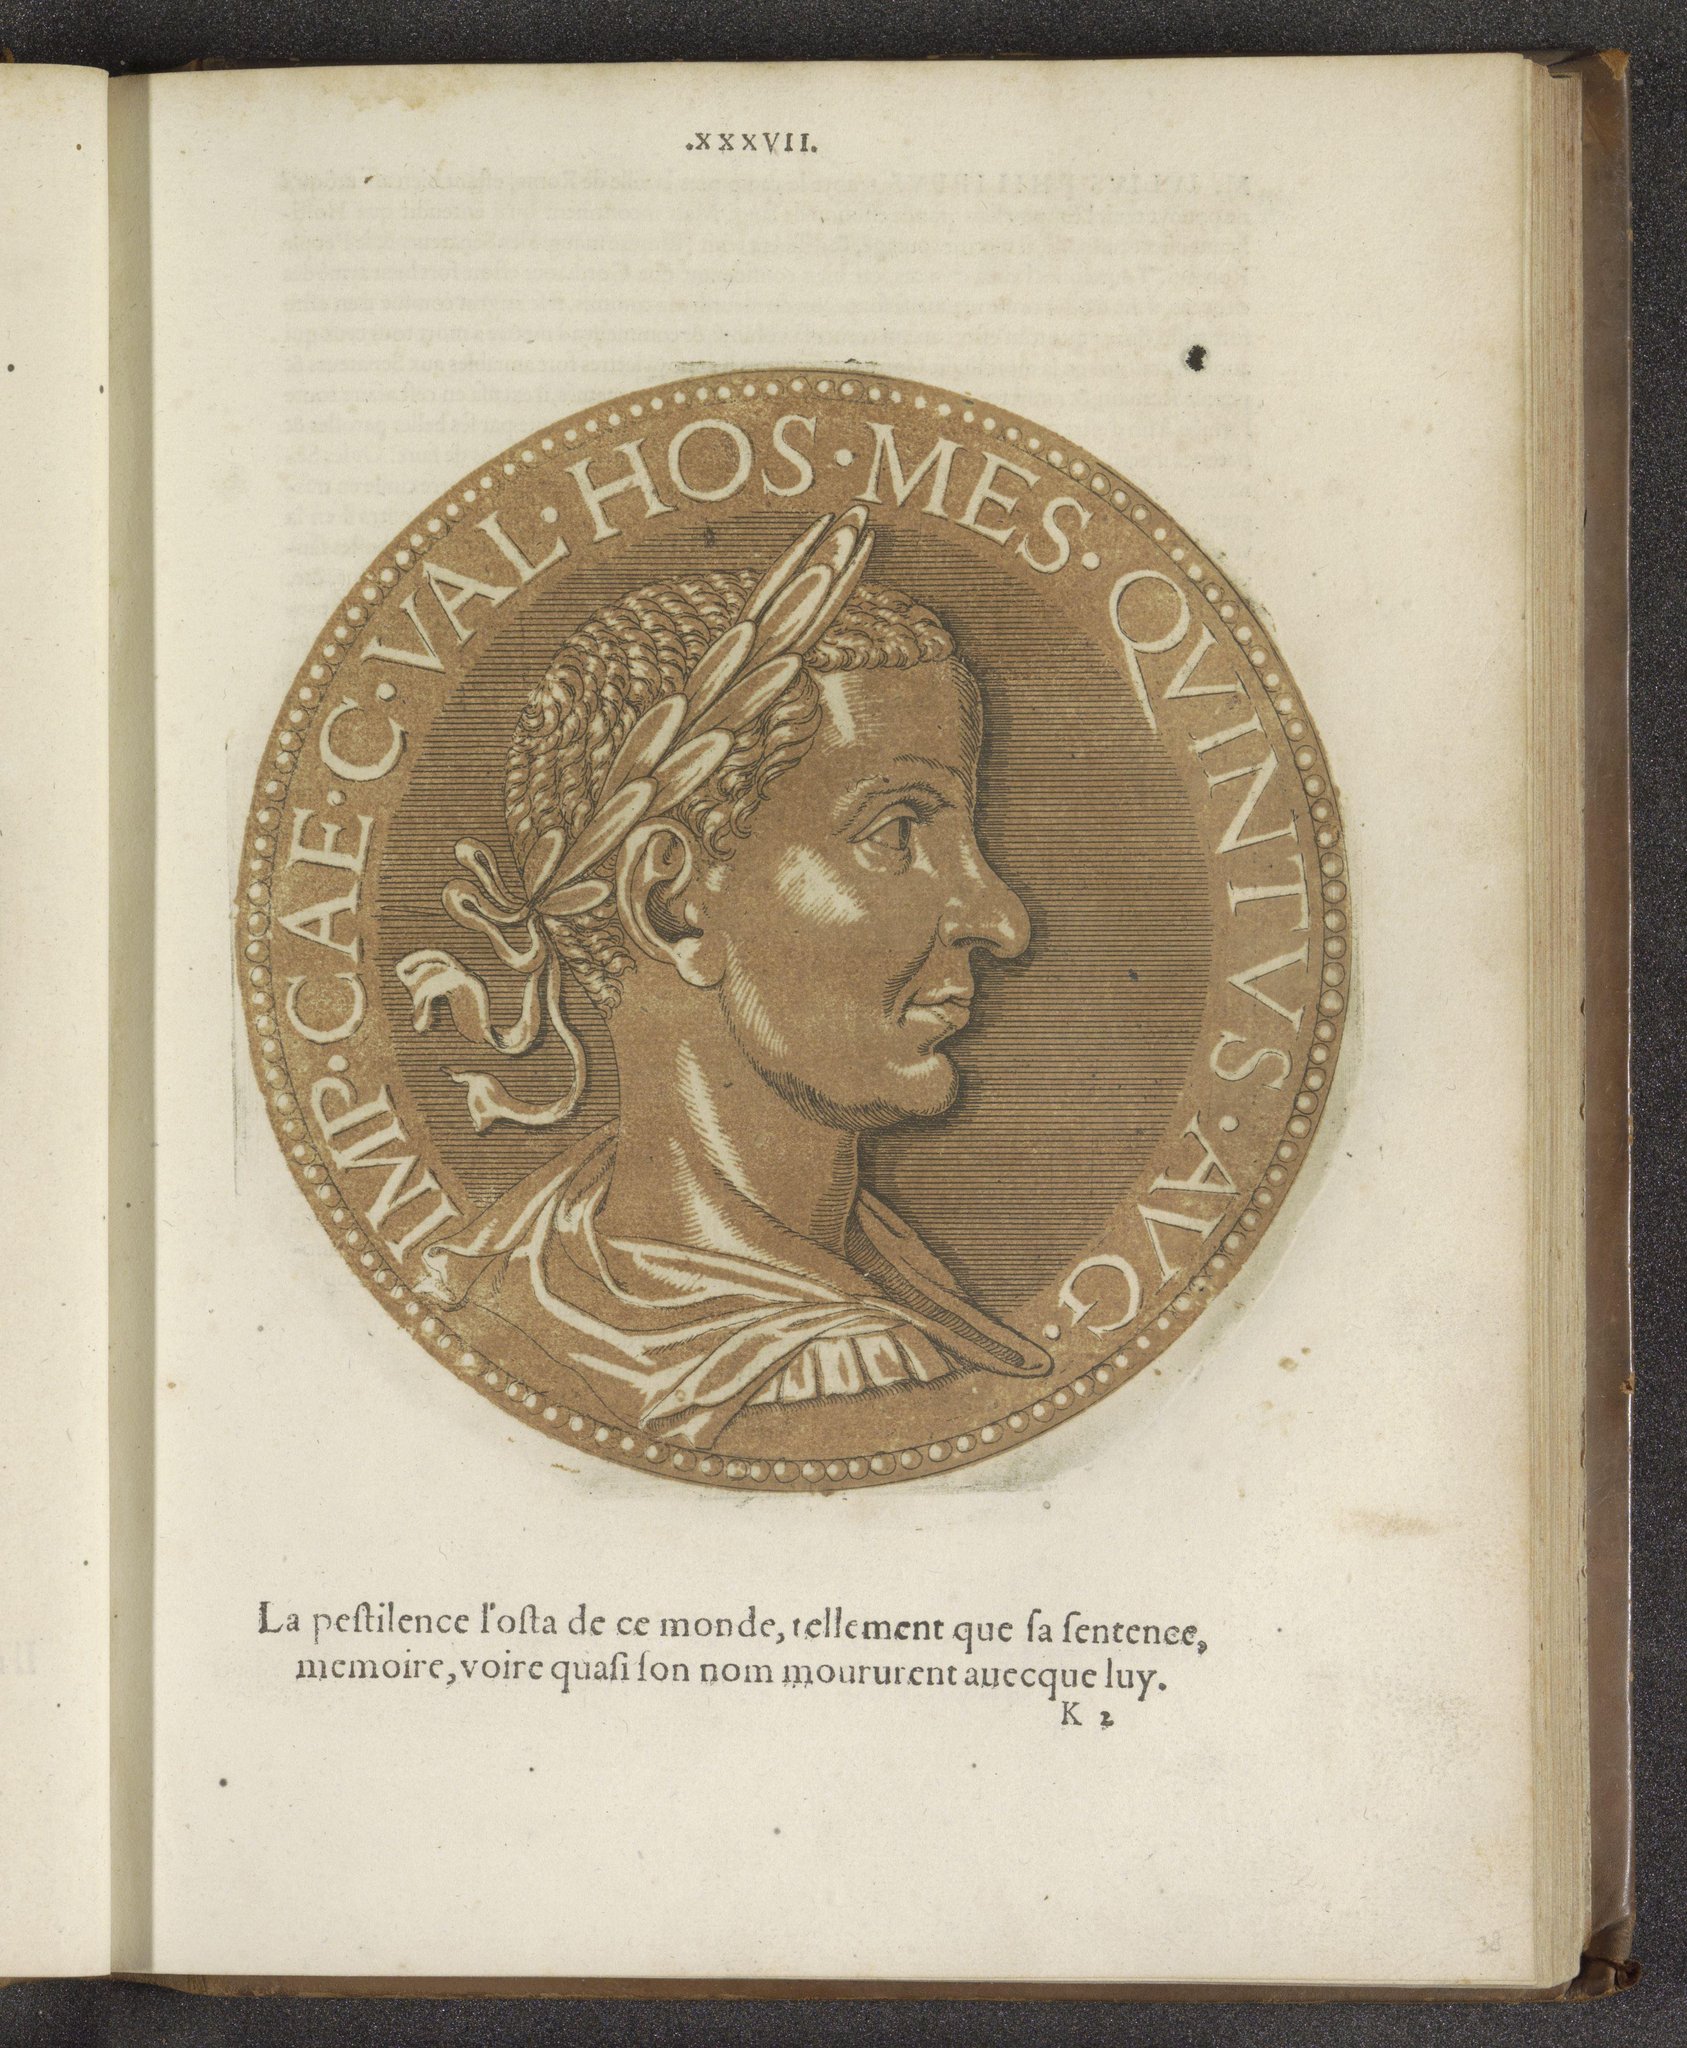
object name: page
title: Portret van keizer Hostilianus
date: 1557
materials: paper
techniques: woodcut, etching, letterpress printing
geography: antwerp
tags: emperor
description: Portret van keizer Hostilianus, op een munt met randschrift. De prent maakt deel uit van een boek over de keizers vanaf Julius Caesar tot en met Karel V en zijn broer Ferdinand.